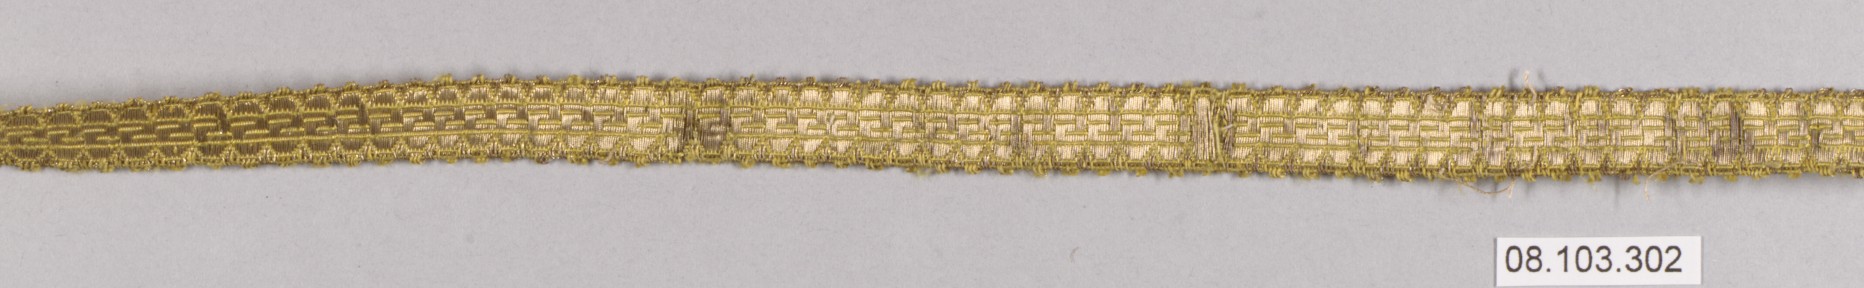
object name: galloon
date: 1601-1800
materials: silk